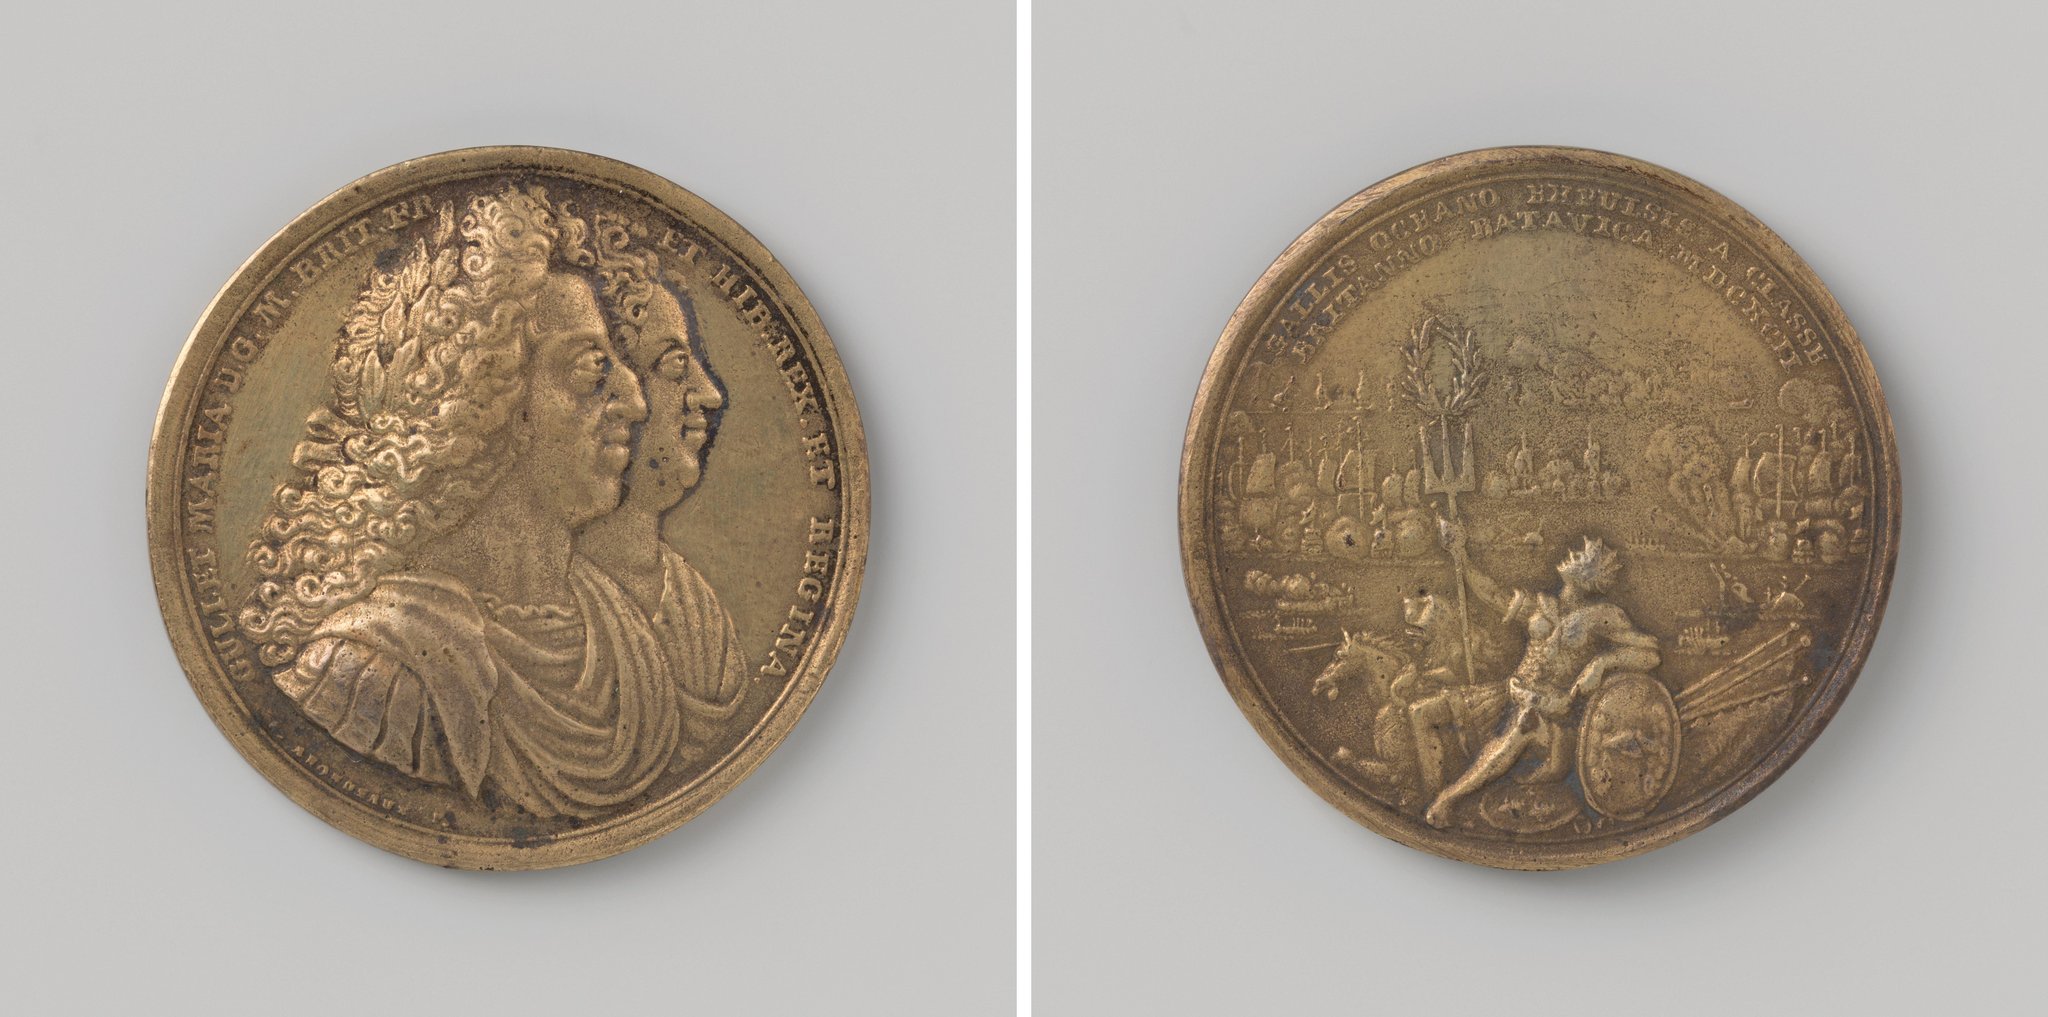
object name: copy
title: Zeeslag bij Kaap La Hogue, de Fransen verslagen door de vloot van Engeland en Holland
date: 1692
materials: bronze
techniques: striking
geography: amsterdam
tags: william iii (prince of orange and king of england, scotland, and ireland), london, maria ii stuart (koningin van engeland, schotland en ierland)